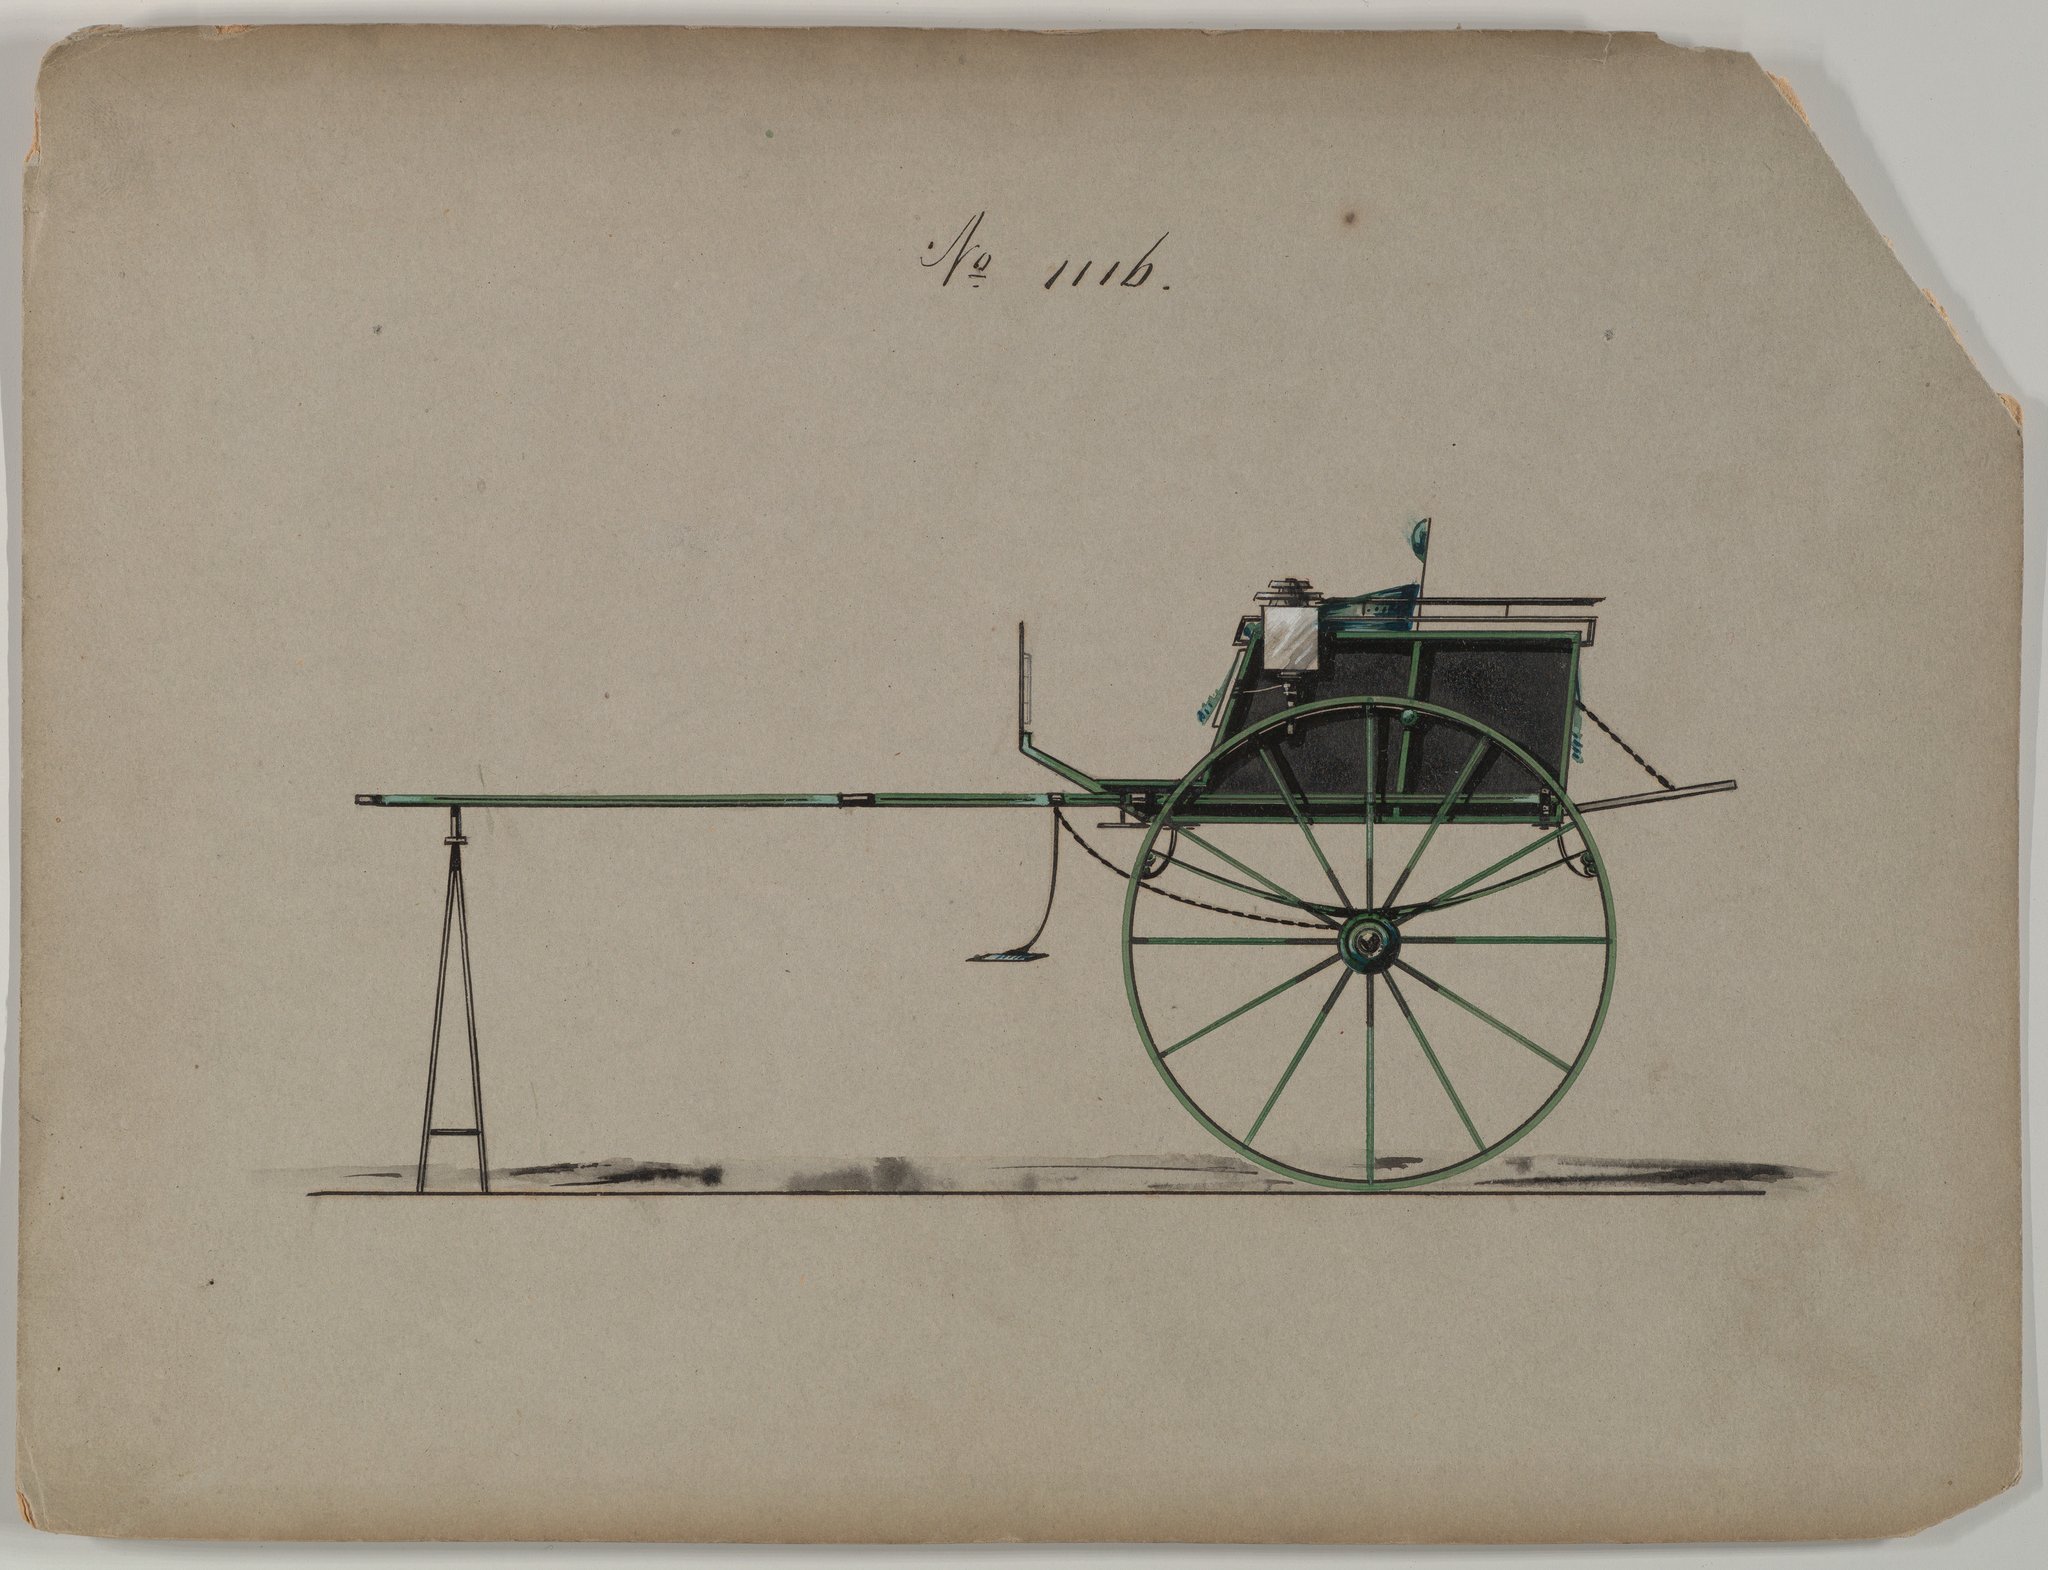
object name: drawing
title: Dog Cart #1116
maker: brewster & co.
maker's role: manufacturer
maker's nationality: american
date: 1870-1874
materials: gouache, graphite, gum arabic, ink, watercolor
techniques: pen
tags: carriages